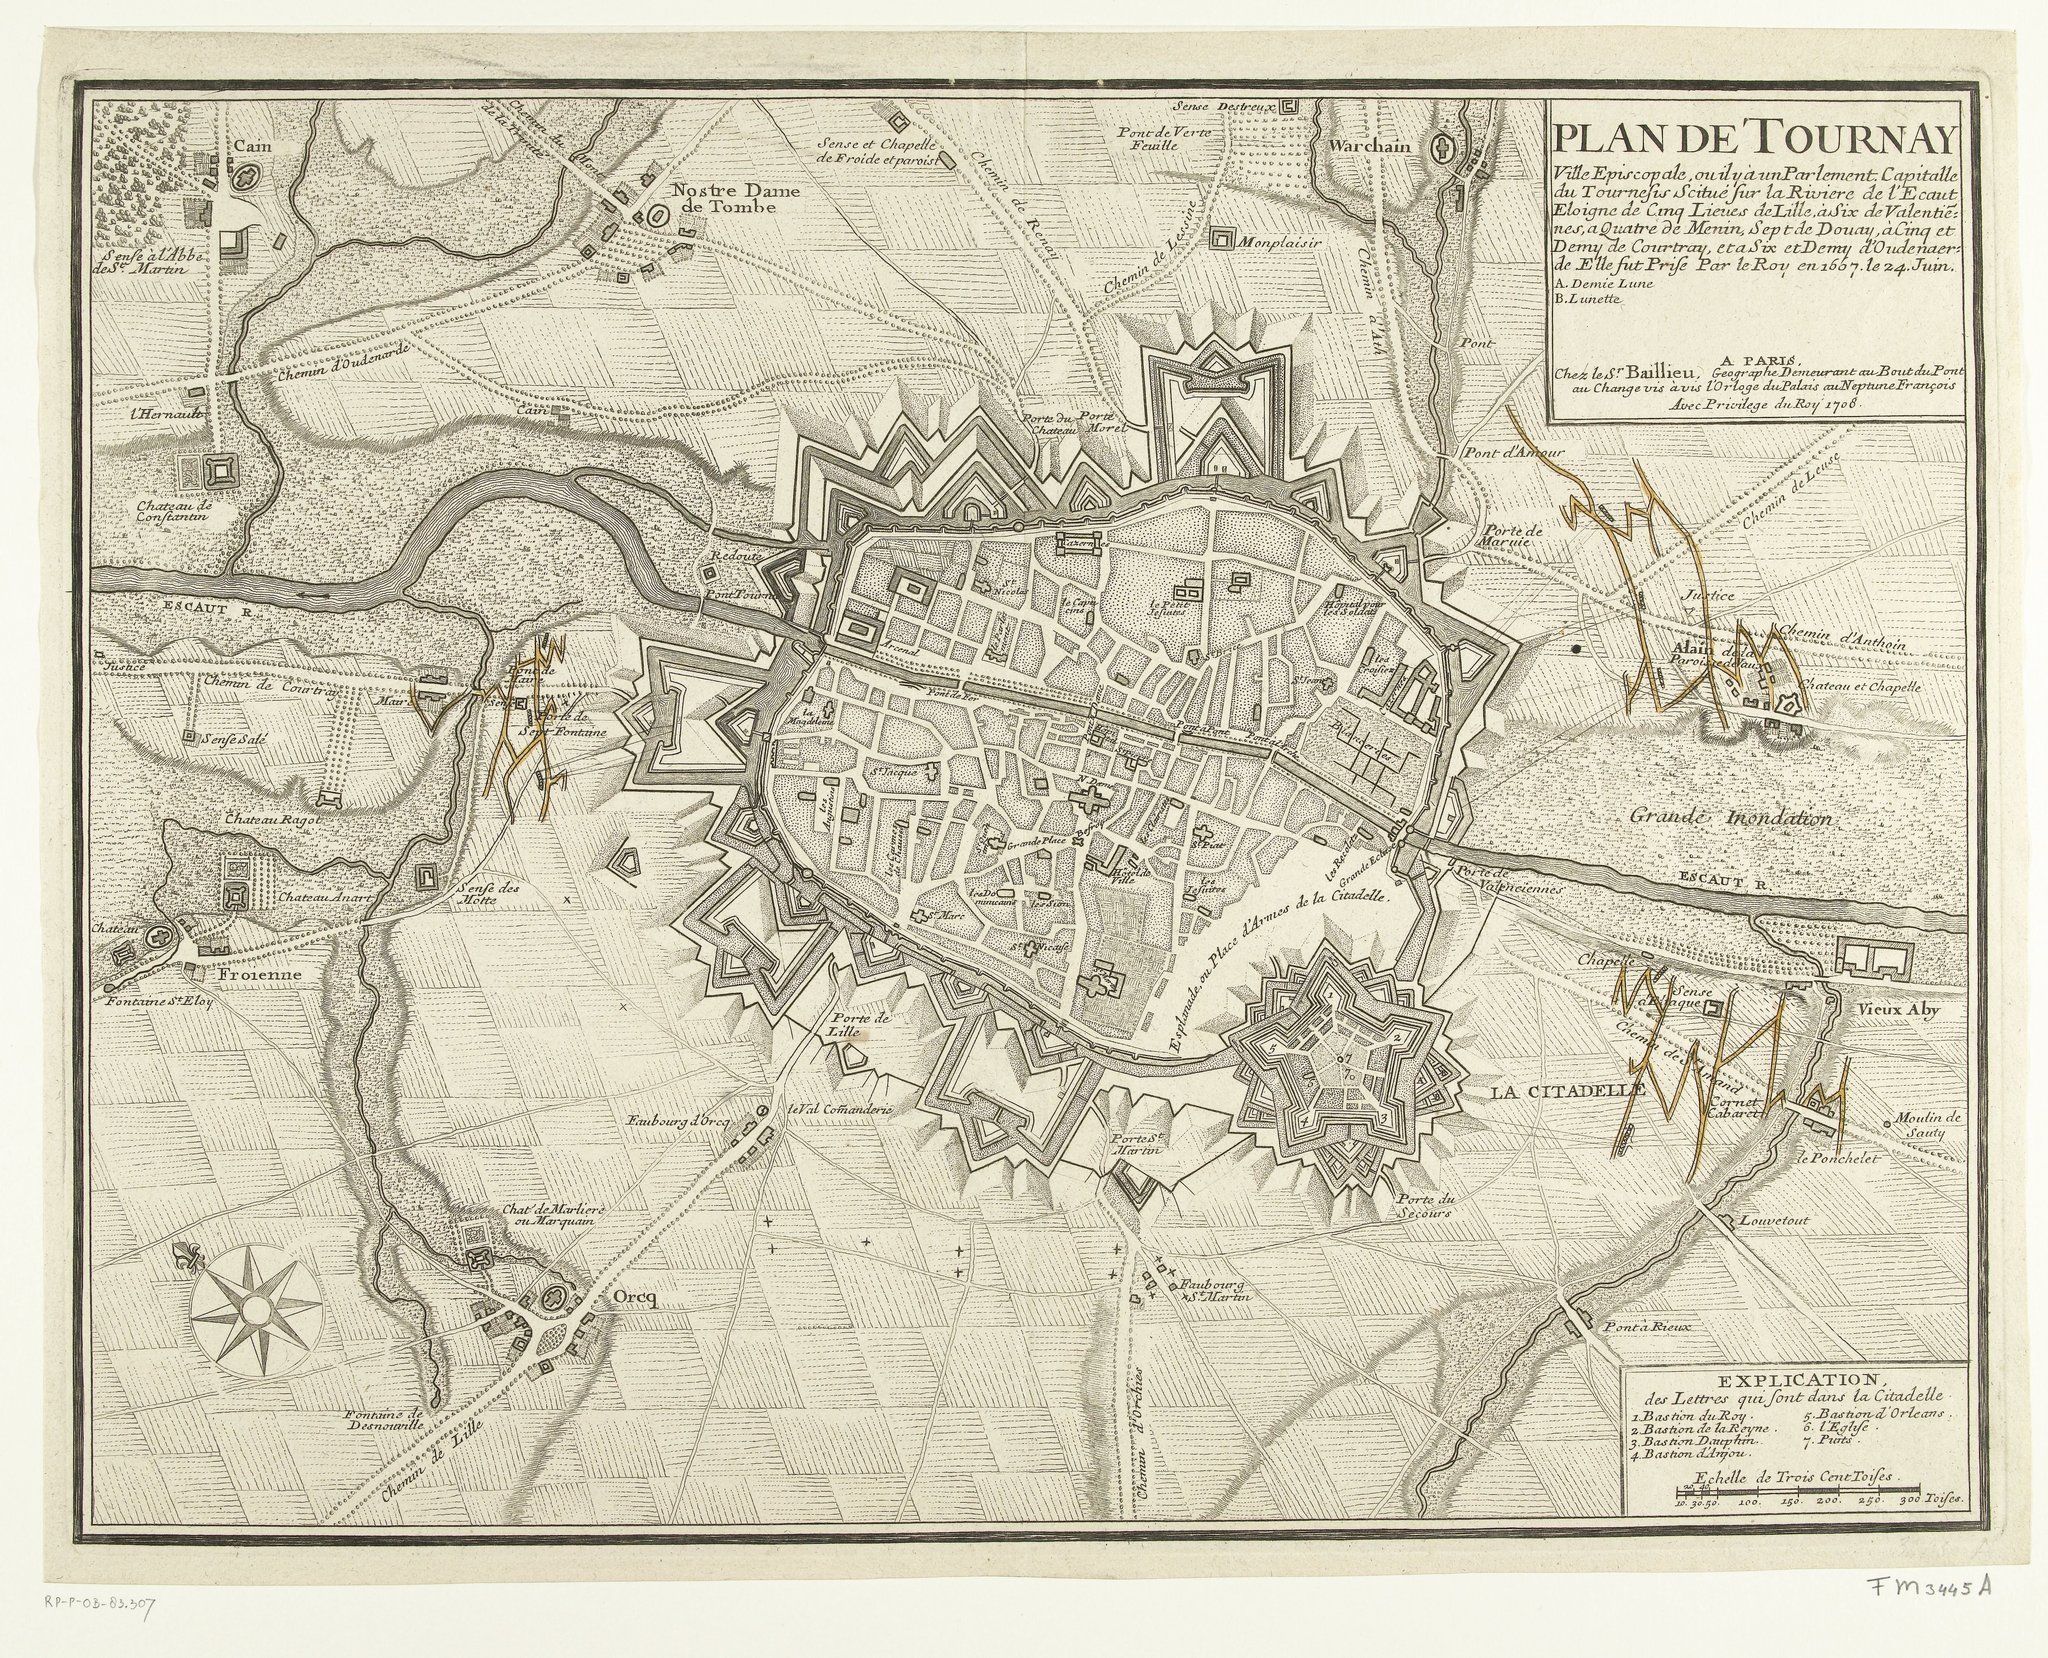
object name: print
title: Plattegrond van Tournai, 1709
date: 1708-1709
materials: paper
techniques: etching, hand coloring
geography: paris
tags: siege, position war, maps of cities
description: Deze prent is gekopieerd door Jacobus Harrewijn voor de prent uitgegeven in: Table des cartes des Pays-Bas et des frontieres de France, avec un recueil des plans des villes, sieges et battailles données entre les hauts allies et la France, Eugene Henry Fricx, Brussel 1712 (FMH 3035/40).